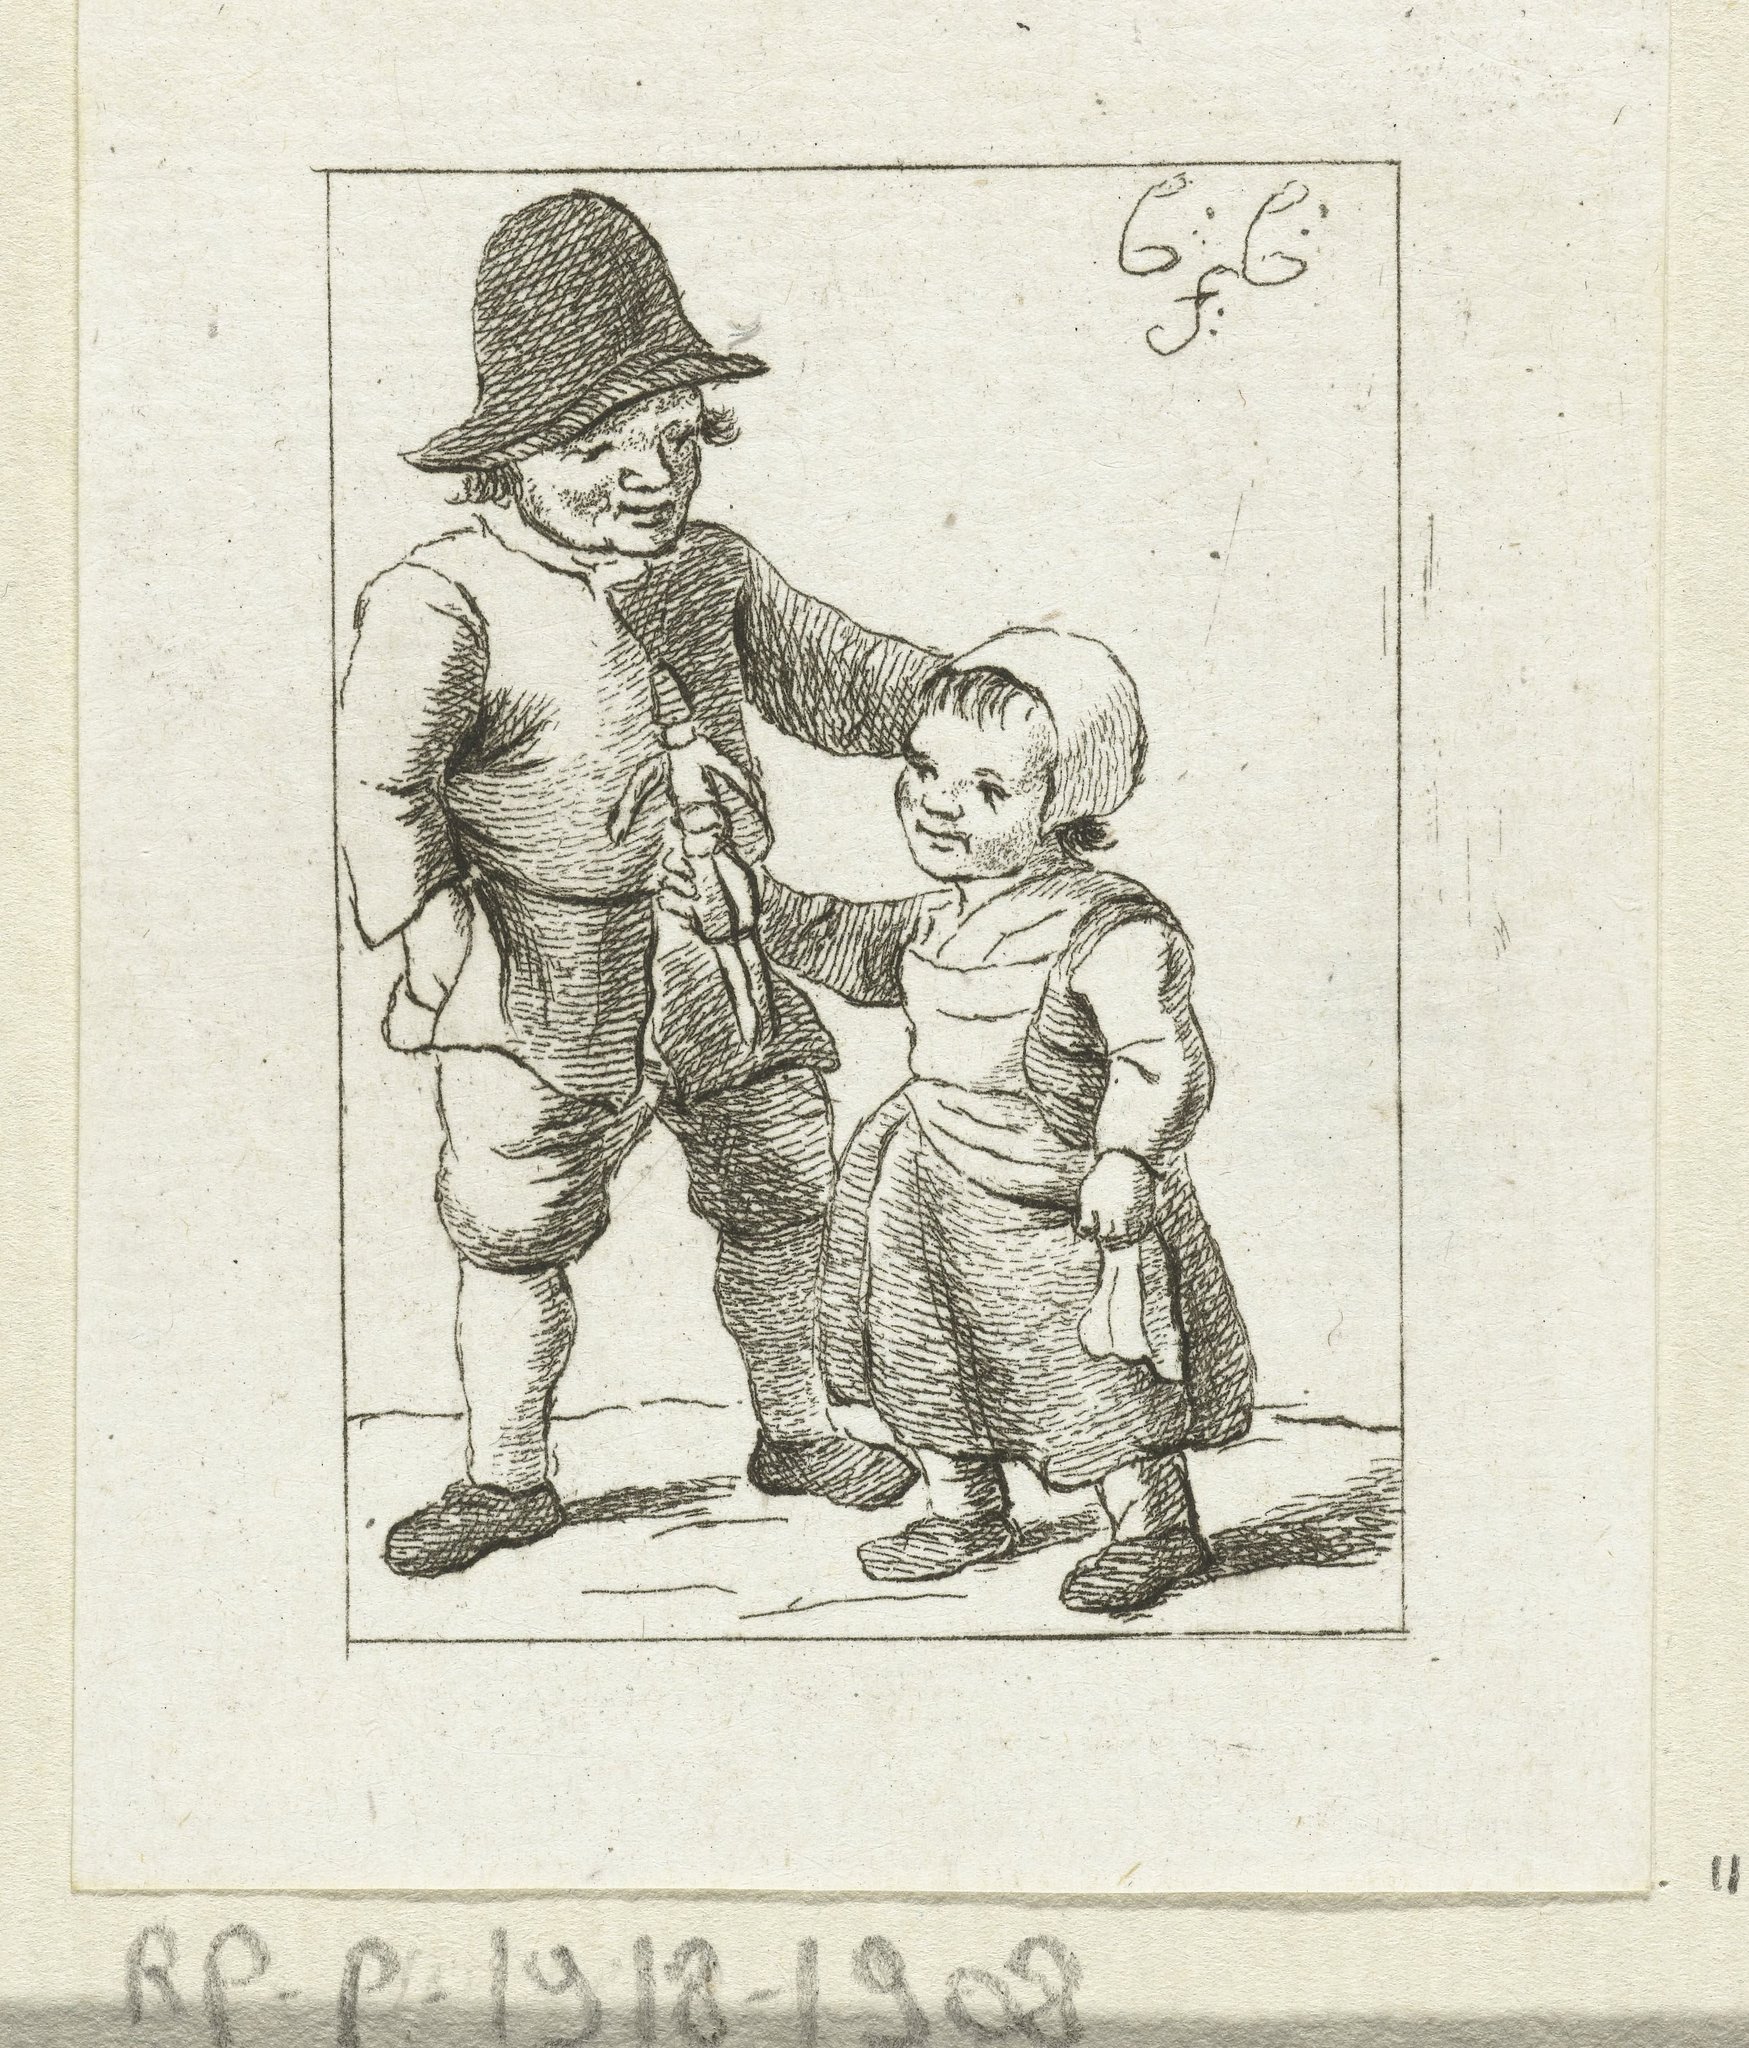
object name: print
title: Jongen en meisje met pop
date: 1779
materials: paper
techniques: etching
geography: leiden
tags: (playing with) dolls, brothers or sisters (second degree family relationships)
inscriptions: collector's mark: Lugt 2233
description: Een meisje houdt een pop in haar rechterhand omhoog. De jongen staat naast haar.